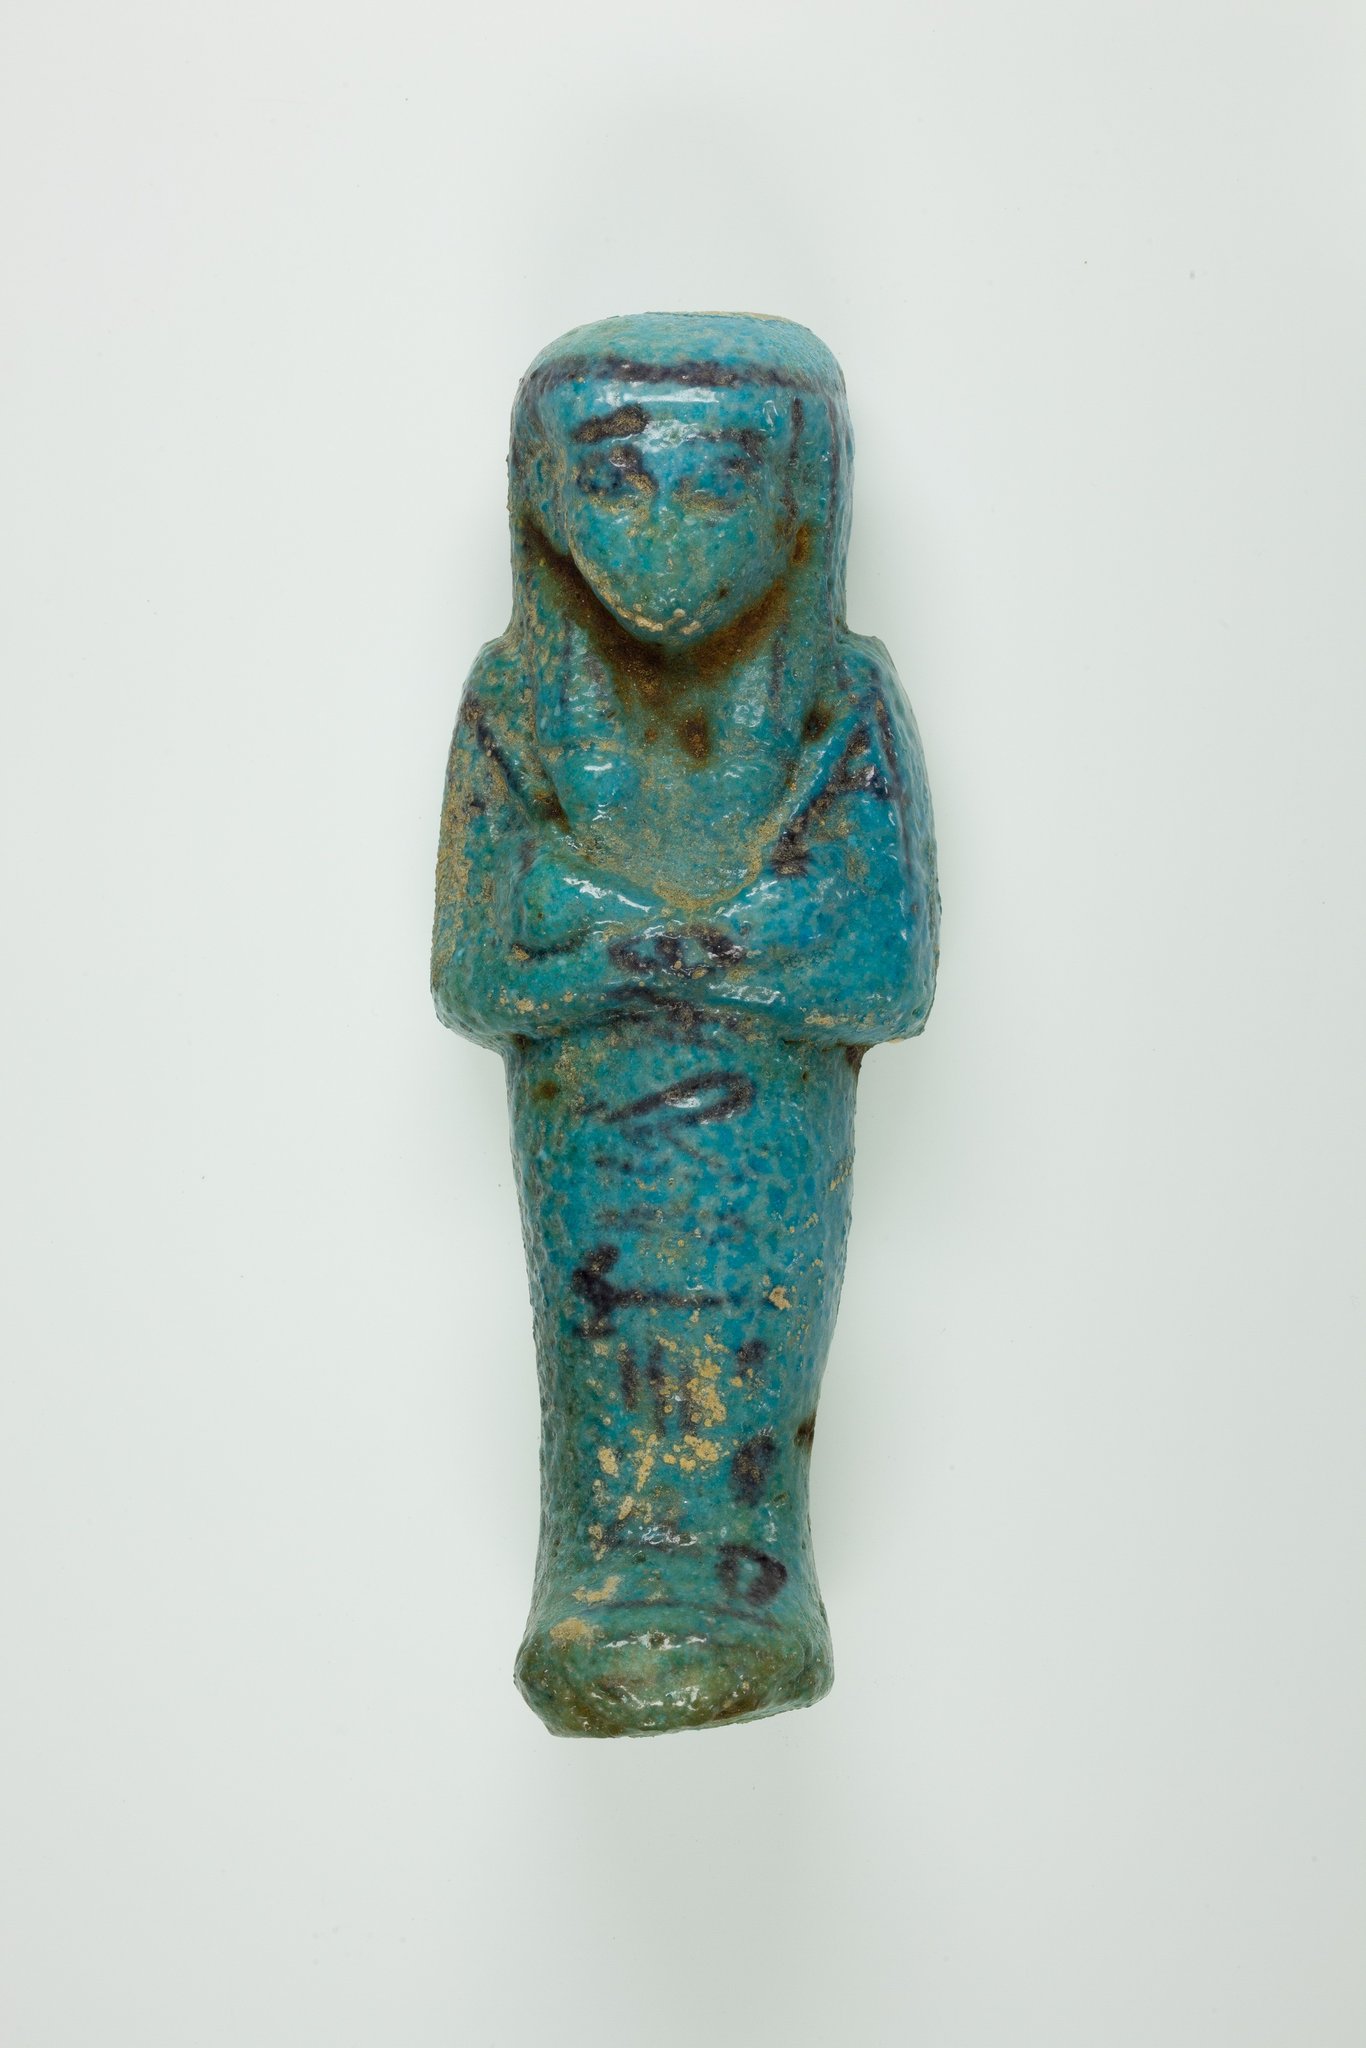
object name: shabti, henettawy c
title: Worker Shabti of Henettawy (C), Daughter of Isetemkheb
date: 990-970 BCE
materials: faience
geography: egypt